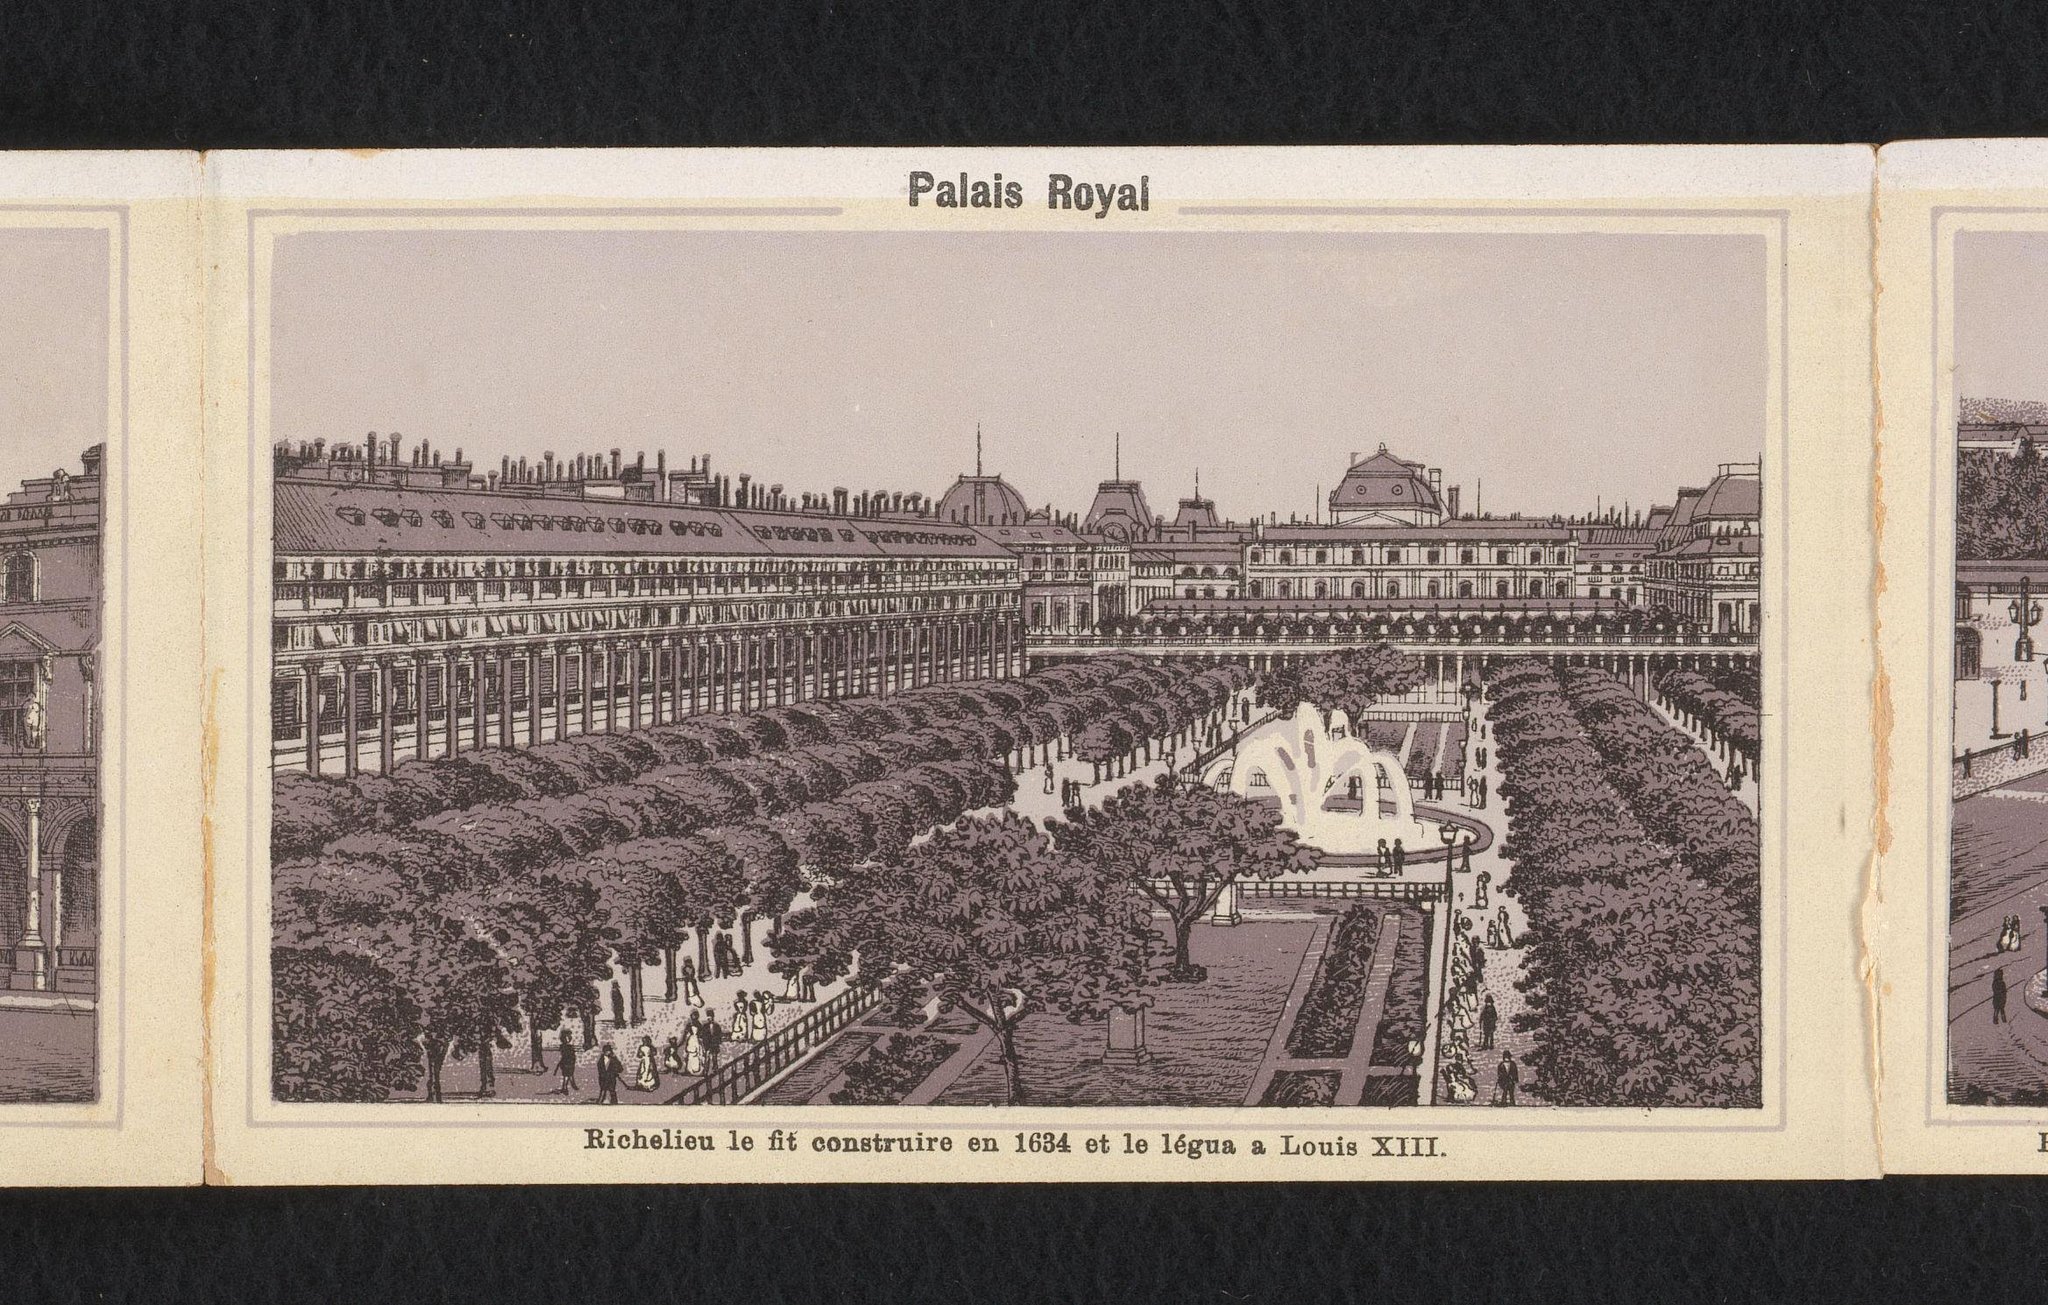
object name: print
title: Palais Royal. Richelieu le fit construire en 1634 et le légua à Louis XIII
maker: Anonymous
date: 1890-1910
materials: cardboard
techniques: lithograph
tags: public gardens, park (+ city(-scape) with figures, staffage), palace